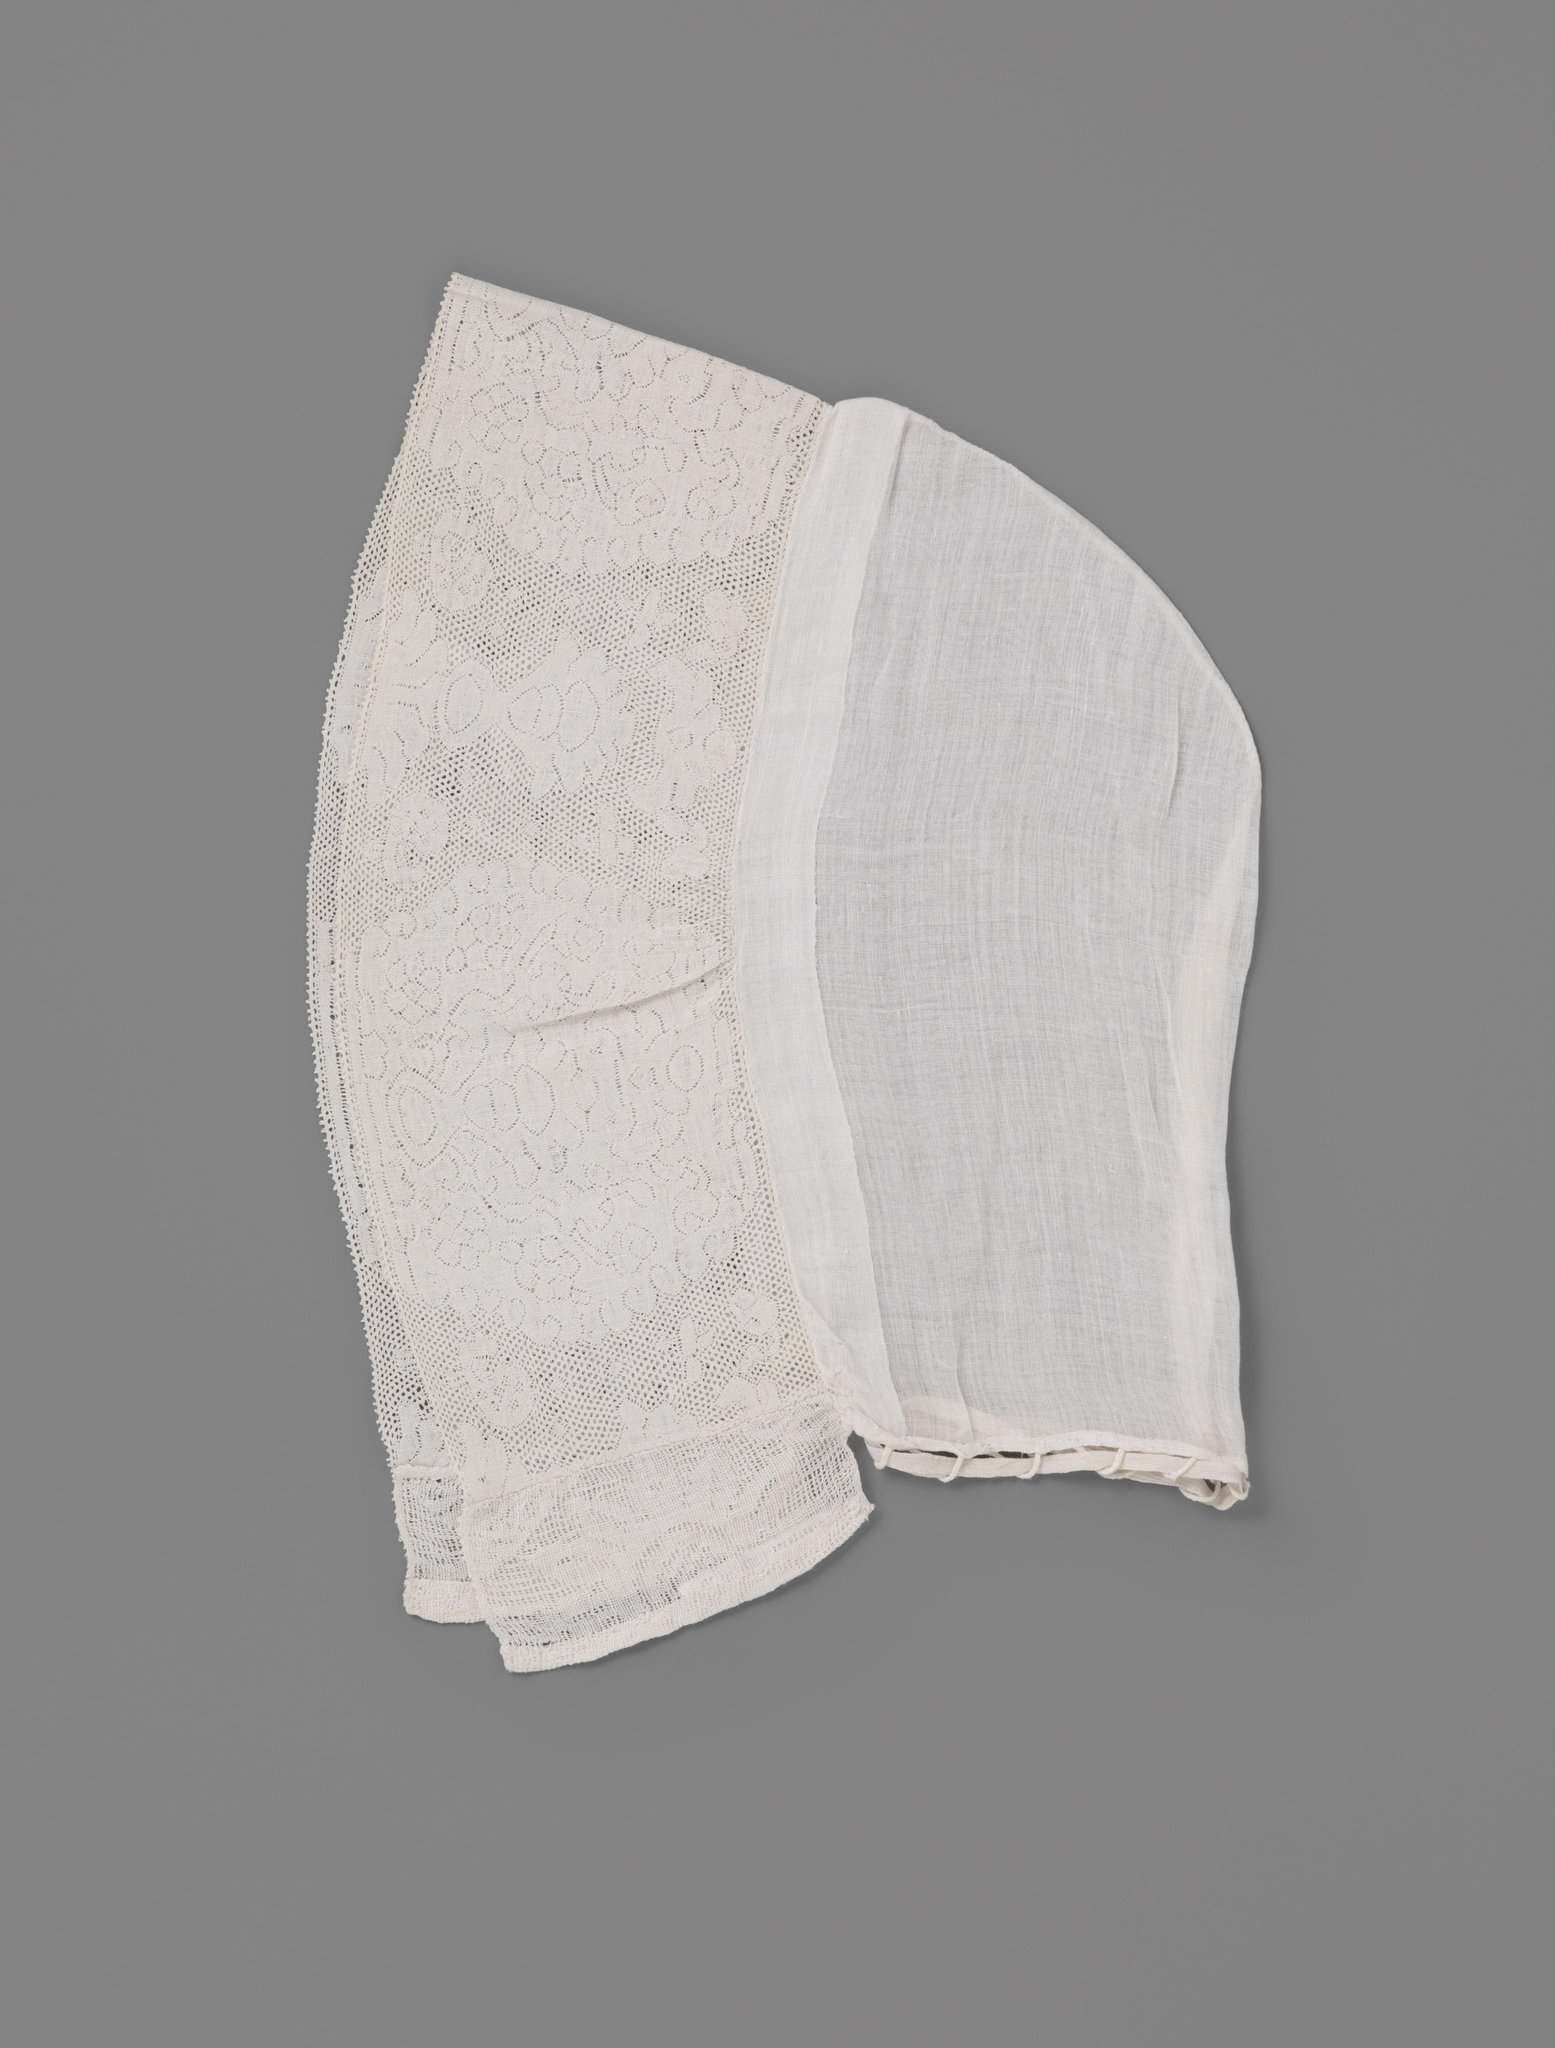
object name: womenswear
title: Muts van streekdracht, van fijn batist afgezet met een brede strook kloskant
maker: Anonymous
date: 1635-1665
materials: textile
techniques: lace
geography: friesland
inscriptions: mark: ‘KL’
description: Muts van streekdracht met ". Techniek. Een fijn batisten muts in afgezet met een brede strook klokant, die de versterkte zeskrantje maas vertoont en linnenslag met à-jourrand. Verlengstukje van geweven gaas. Kantpatroon. Grote gelobde ovale bloemen-met binnenvulling van een vaas met bloemenwisselen af met losse vazen en strooigoed.